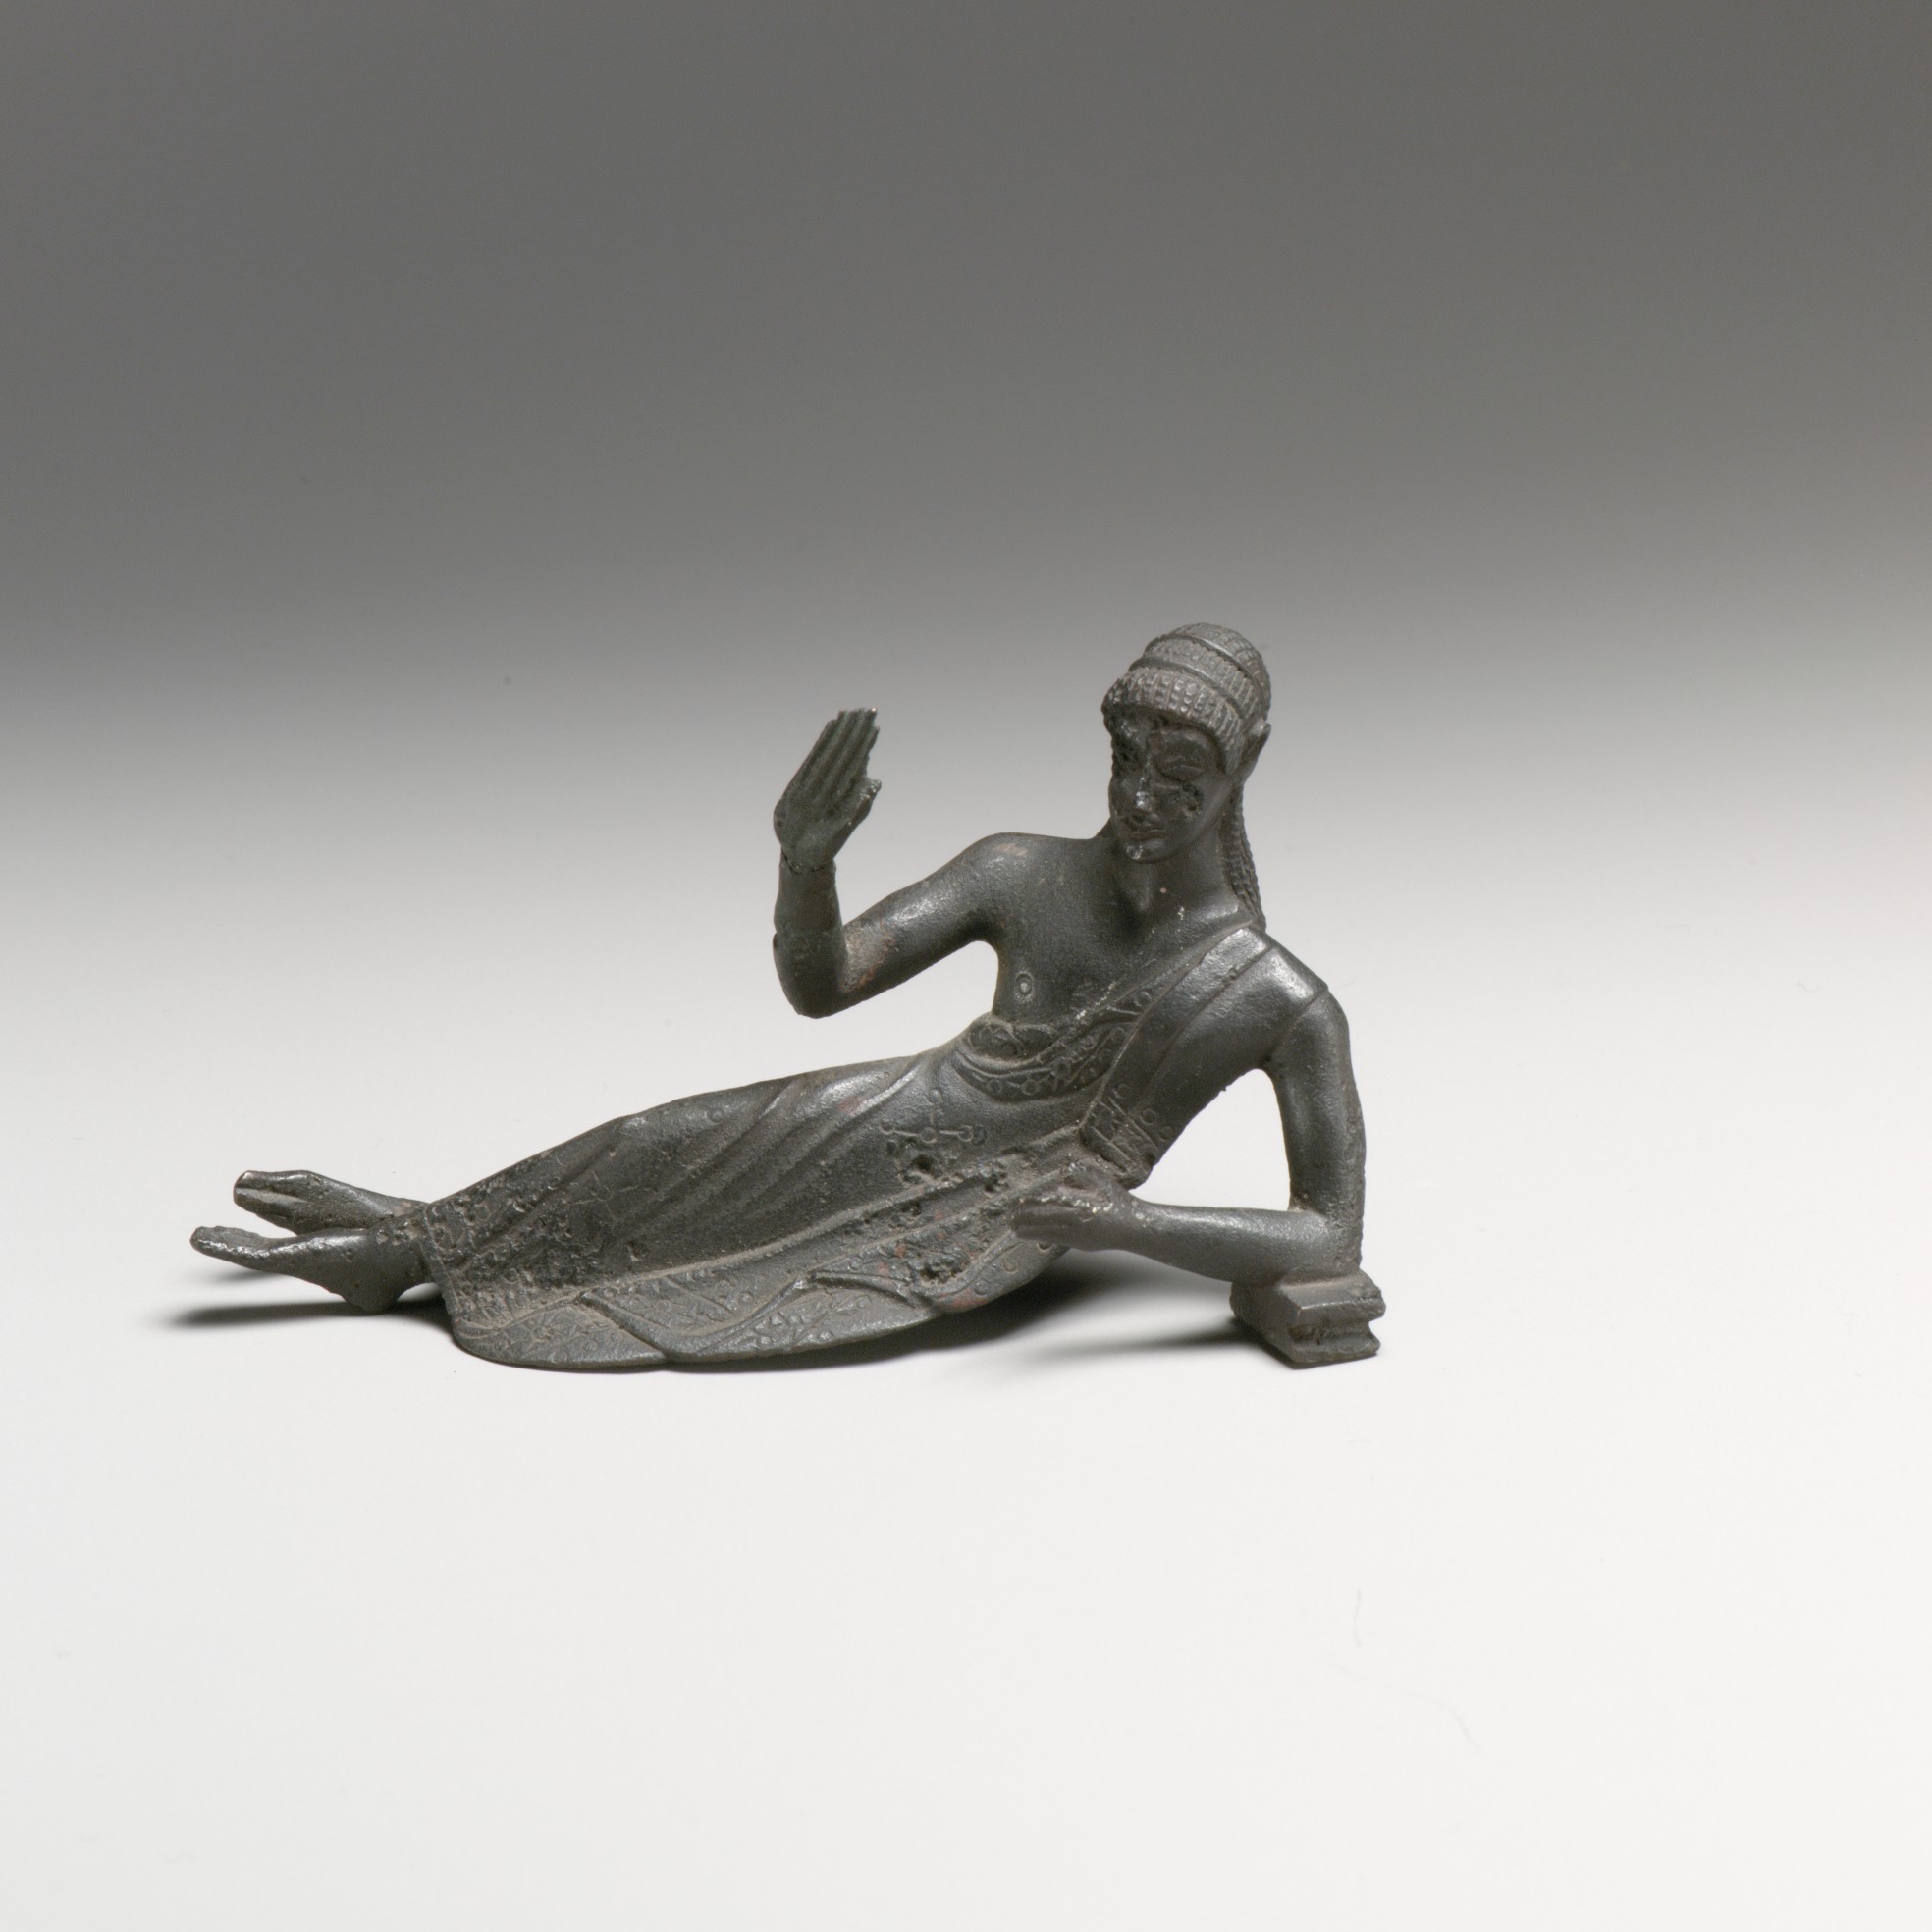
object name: statuette of a youth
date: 7000 BCE-330 CE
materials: bronze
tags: men